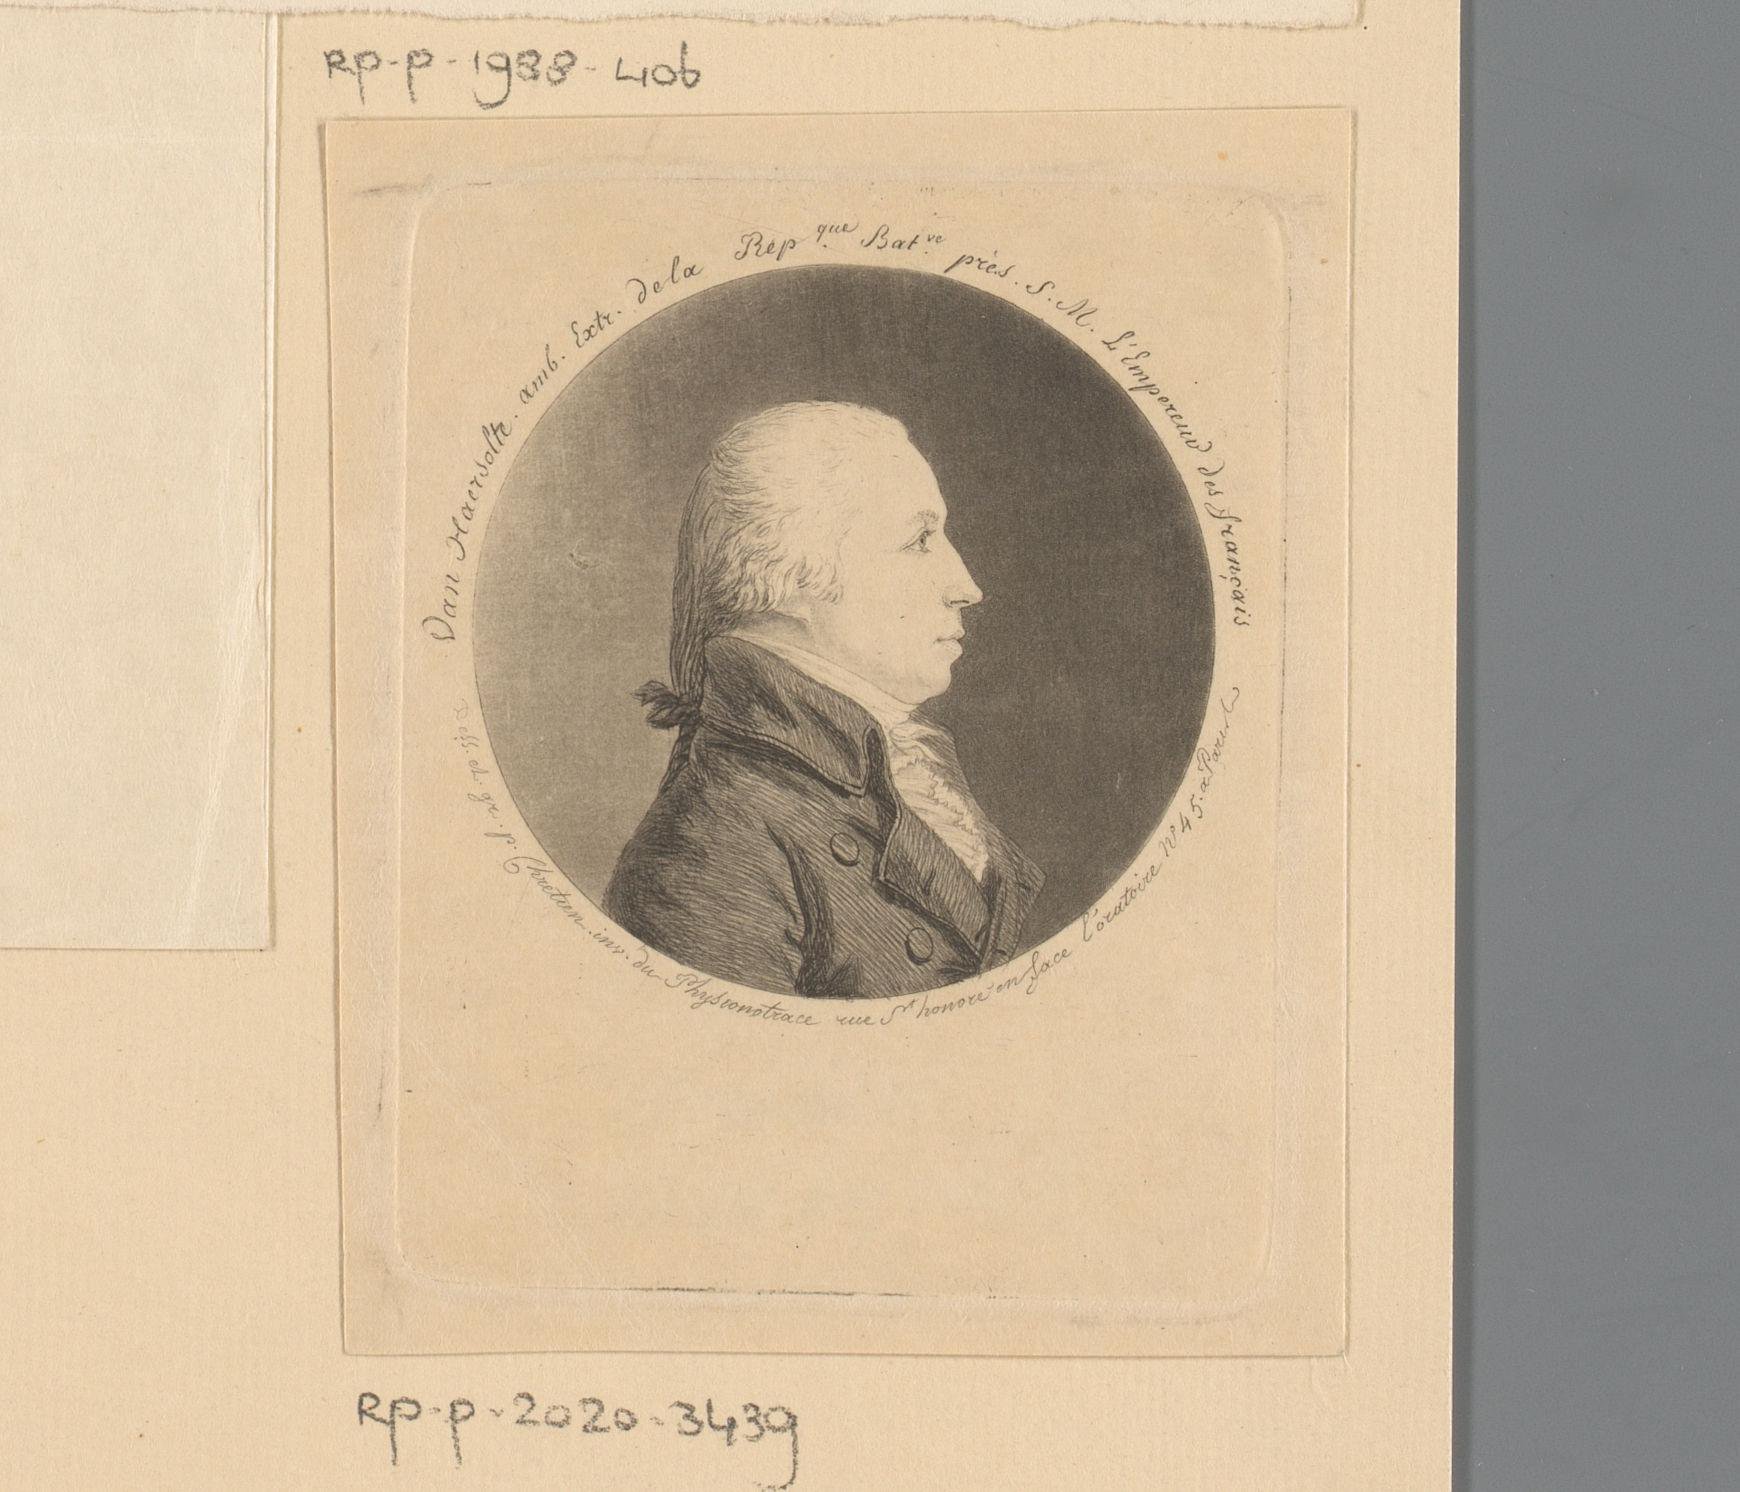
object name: physionotrace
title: Van Haersolte. Amb. extr. de la Repque. Batve. près s.m. l'empereur Français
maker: gilles louis chrétien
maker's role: print maker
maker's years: 1754-1811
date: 1785-1811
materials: paper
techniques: aquatint, etching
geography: paris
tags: silhouette-apparatus, 'physionotrace', historical persons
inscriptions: collector's mark: Lugt 2228